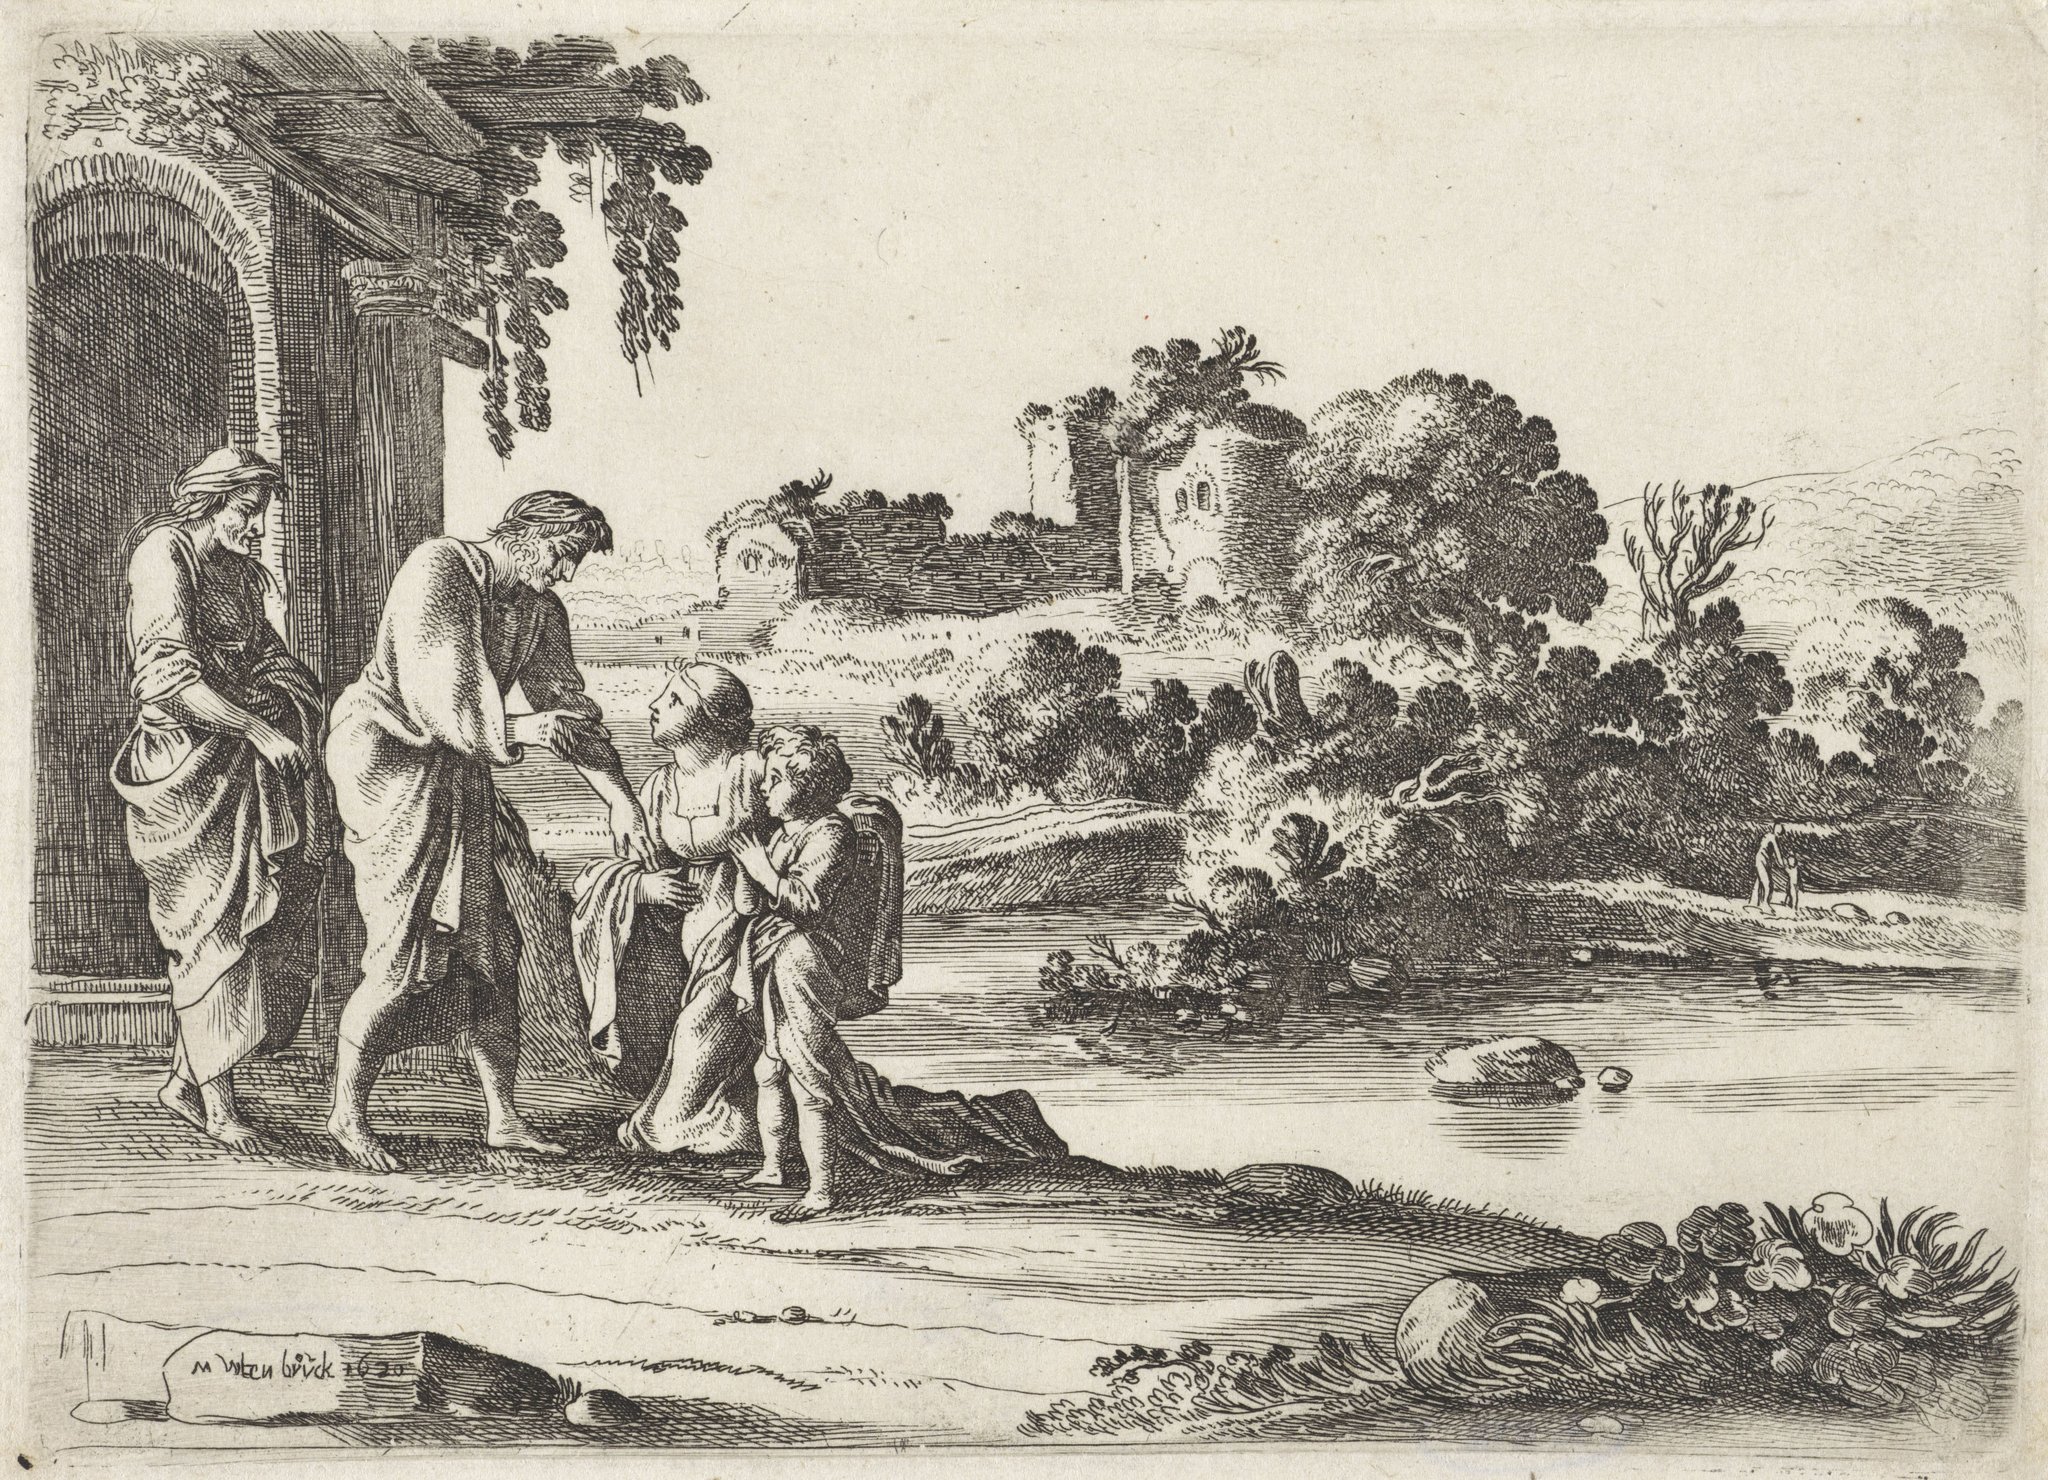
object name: print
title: Het verhaal van Hagar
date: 1620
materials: paper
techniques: drypoint, engraving, etching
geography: amsterdam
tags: the banishment of hagar and ishmael (genesis 21:9-21)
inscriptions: collector's mark: Lugt 2228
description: Sara en Abraham kijken neer op de knielende Hagar. Naast haar staat Ismael. Op de achtergrond een vijver en enkele ruïnes. In de linkerbenedenhoek is de prent genummerd als III.